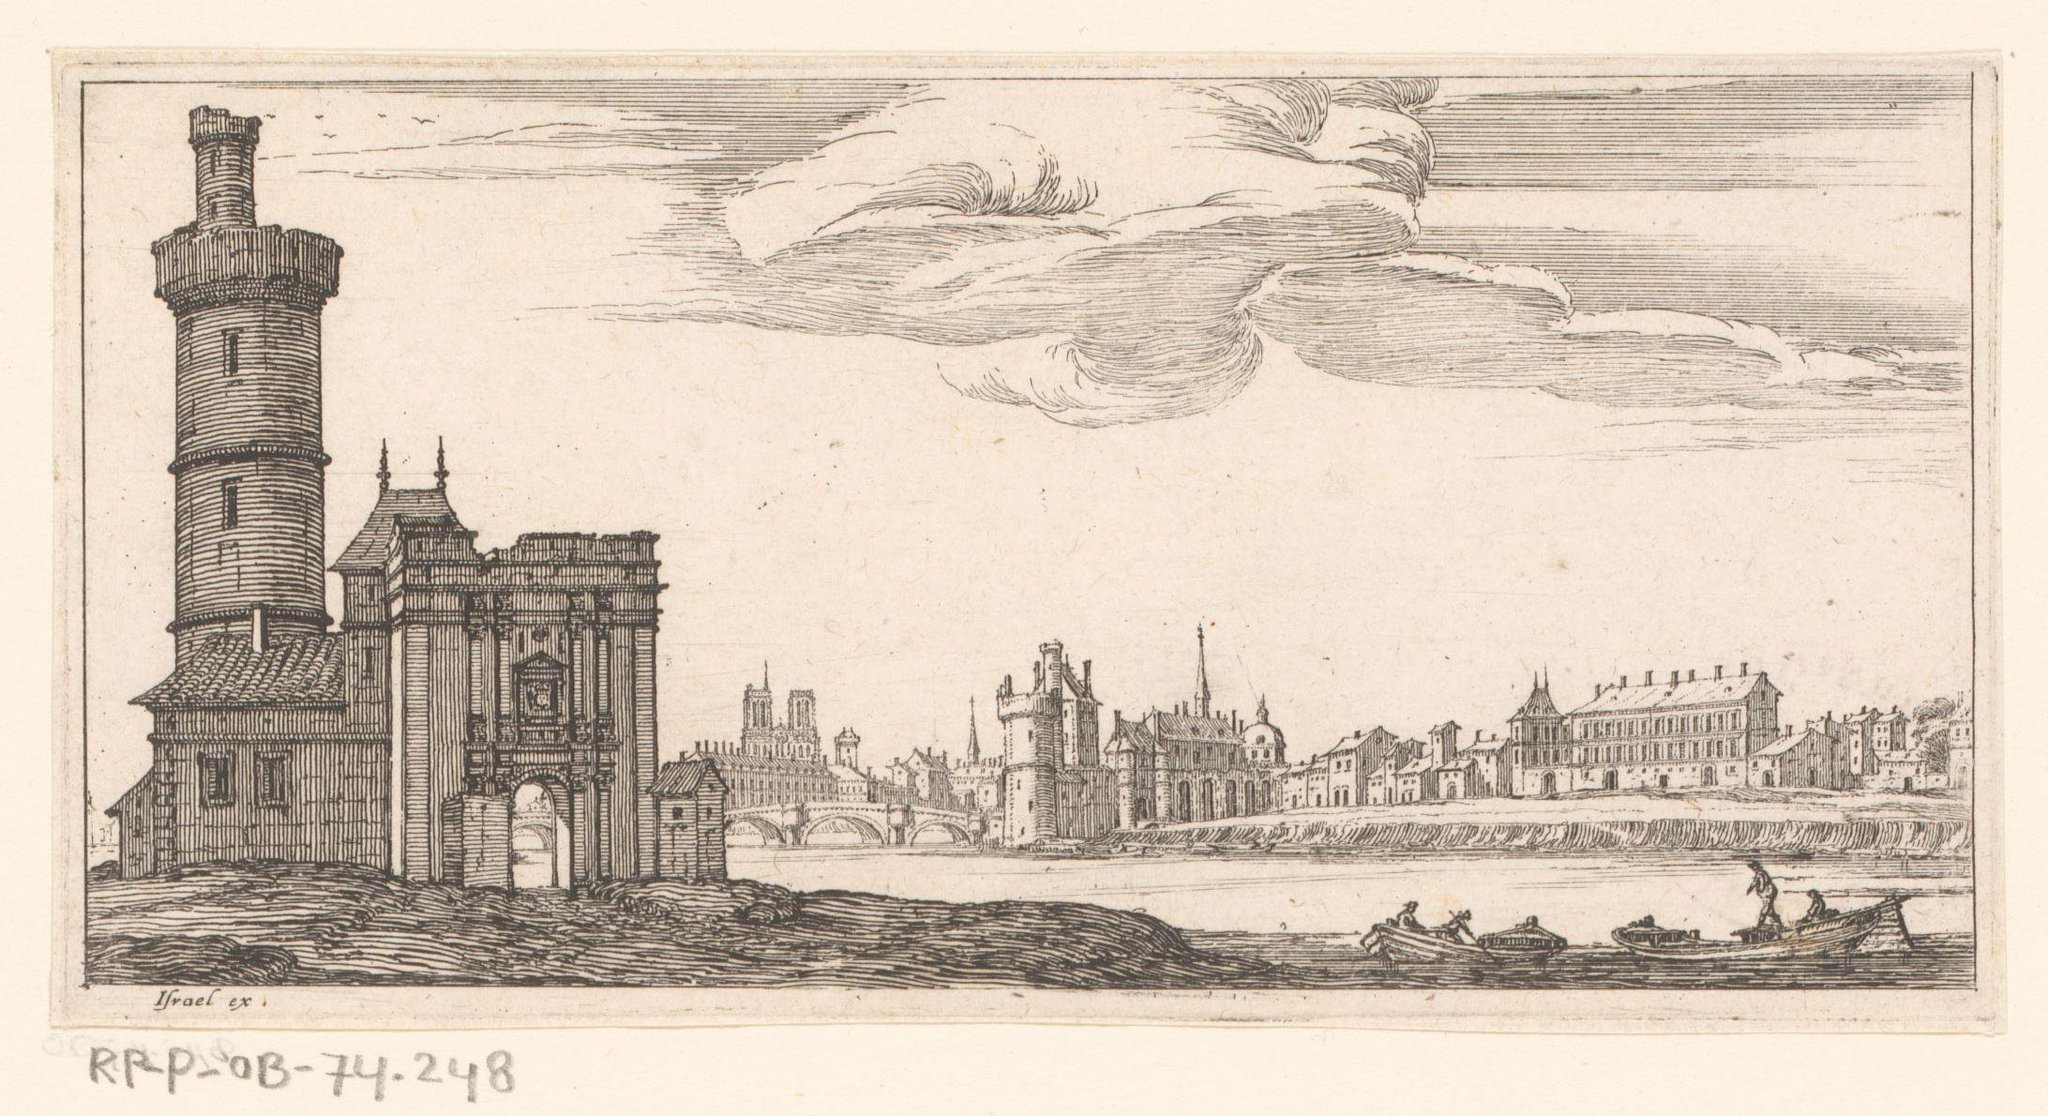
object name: print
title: Gezichten op Parijs en omgeving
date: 1631-1661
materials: paper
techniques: etching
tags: landscapes, paris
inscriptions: collector's mark: Lugt 240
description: Nummer is afgesneden: prent had binnen de serie van vijf vermoedelijk nummer 4.